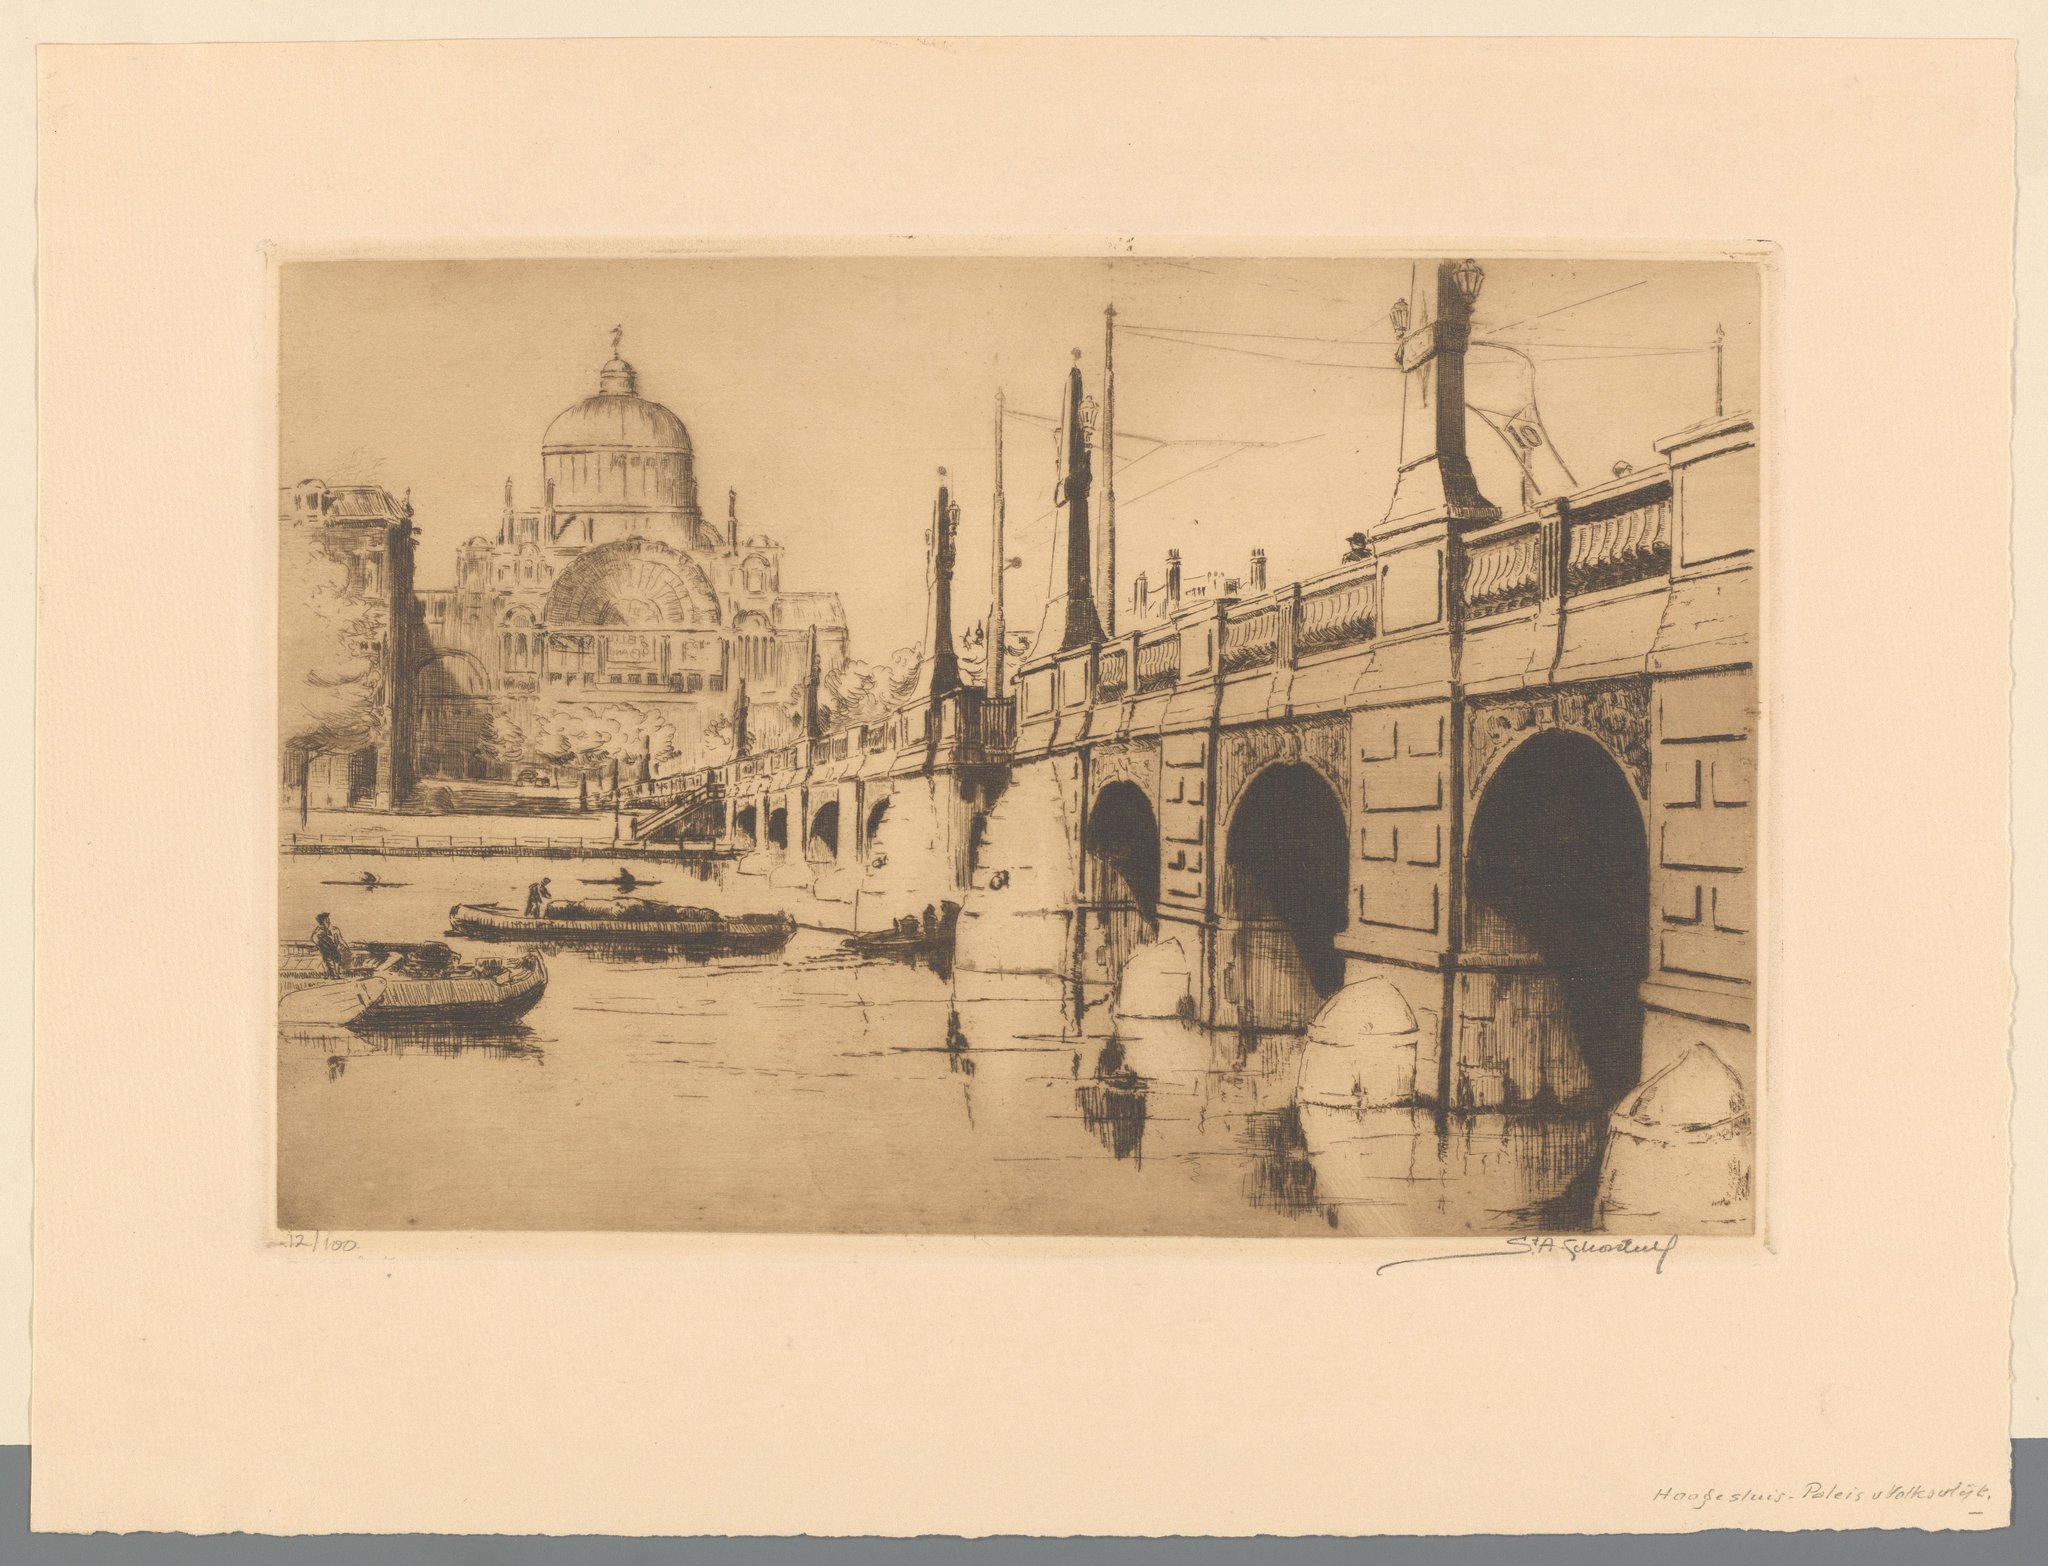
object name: print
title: Gezicht op het Paleis voor Volksvlijt met daarvoor de Hogesluis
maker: st. a. schouten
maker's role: print maker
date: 1925-1930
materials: paper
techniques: etching, intaglio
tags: rowing-boat, canoe, etc., bridge in city across river, canal, etc., amsterdam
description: Aangezien geboorte- en sterfdatum van de kunstenaar onbekend zijn, is voor de rechtenbepaling van dit object de productiedatum gehanteerd. De titel van deze prent is overgenomen van de rekening voor deze prenten, door de kunstenaar geschreven.